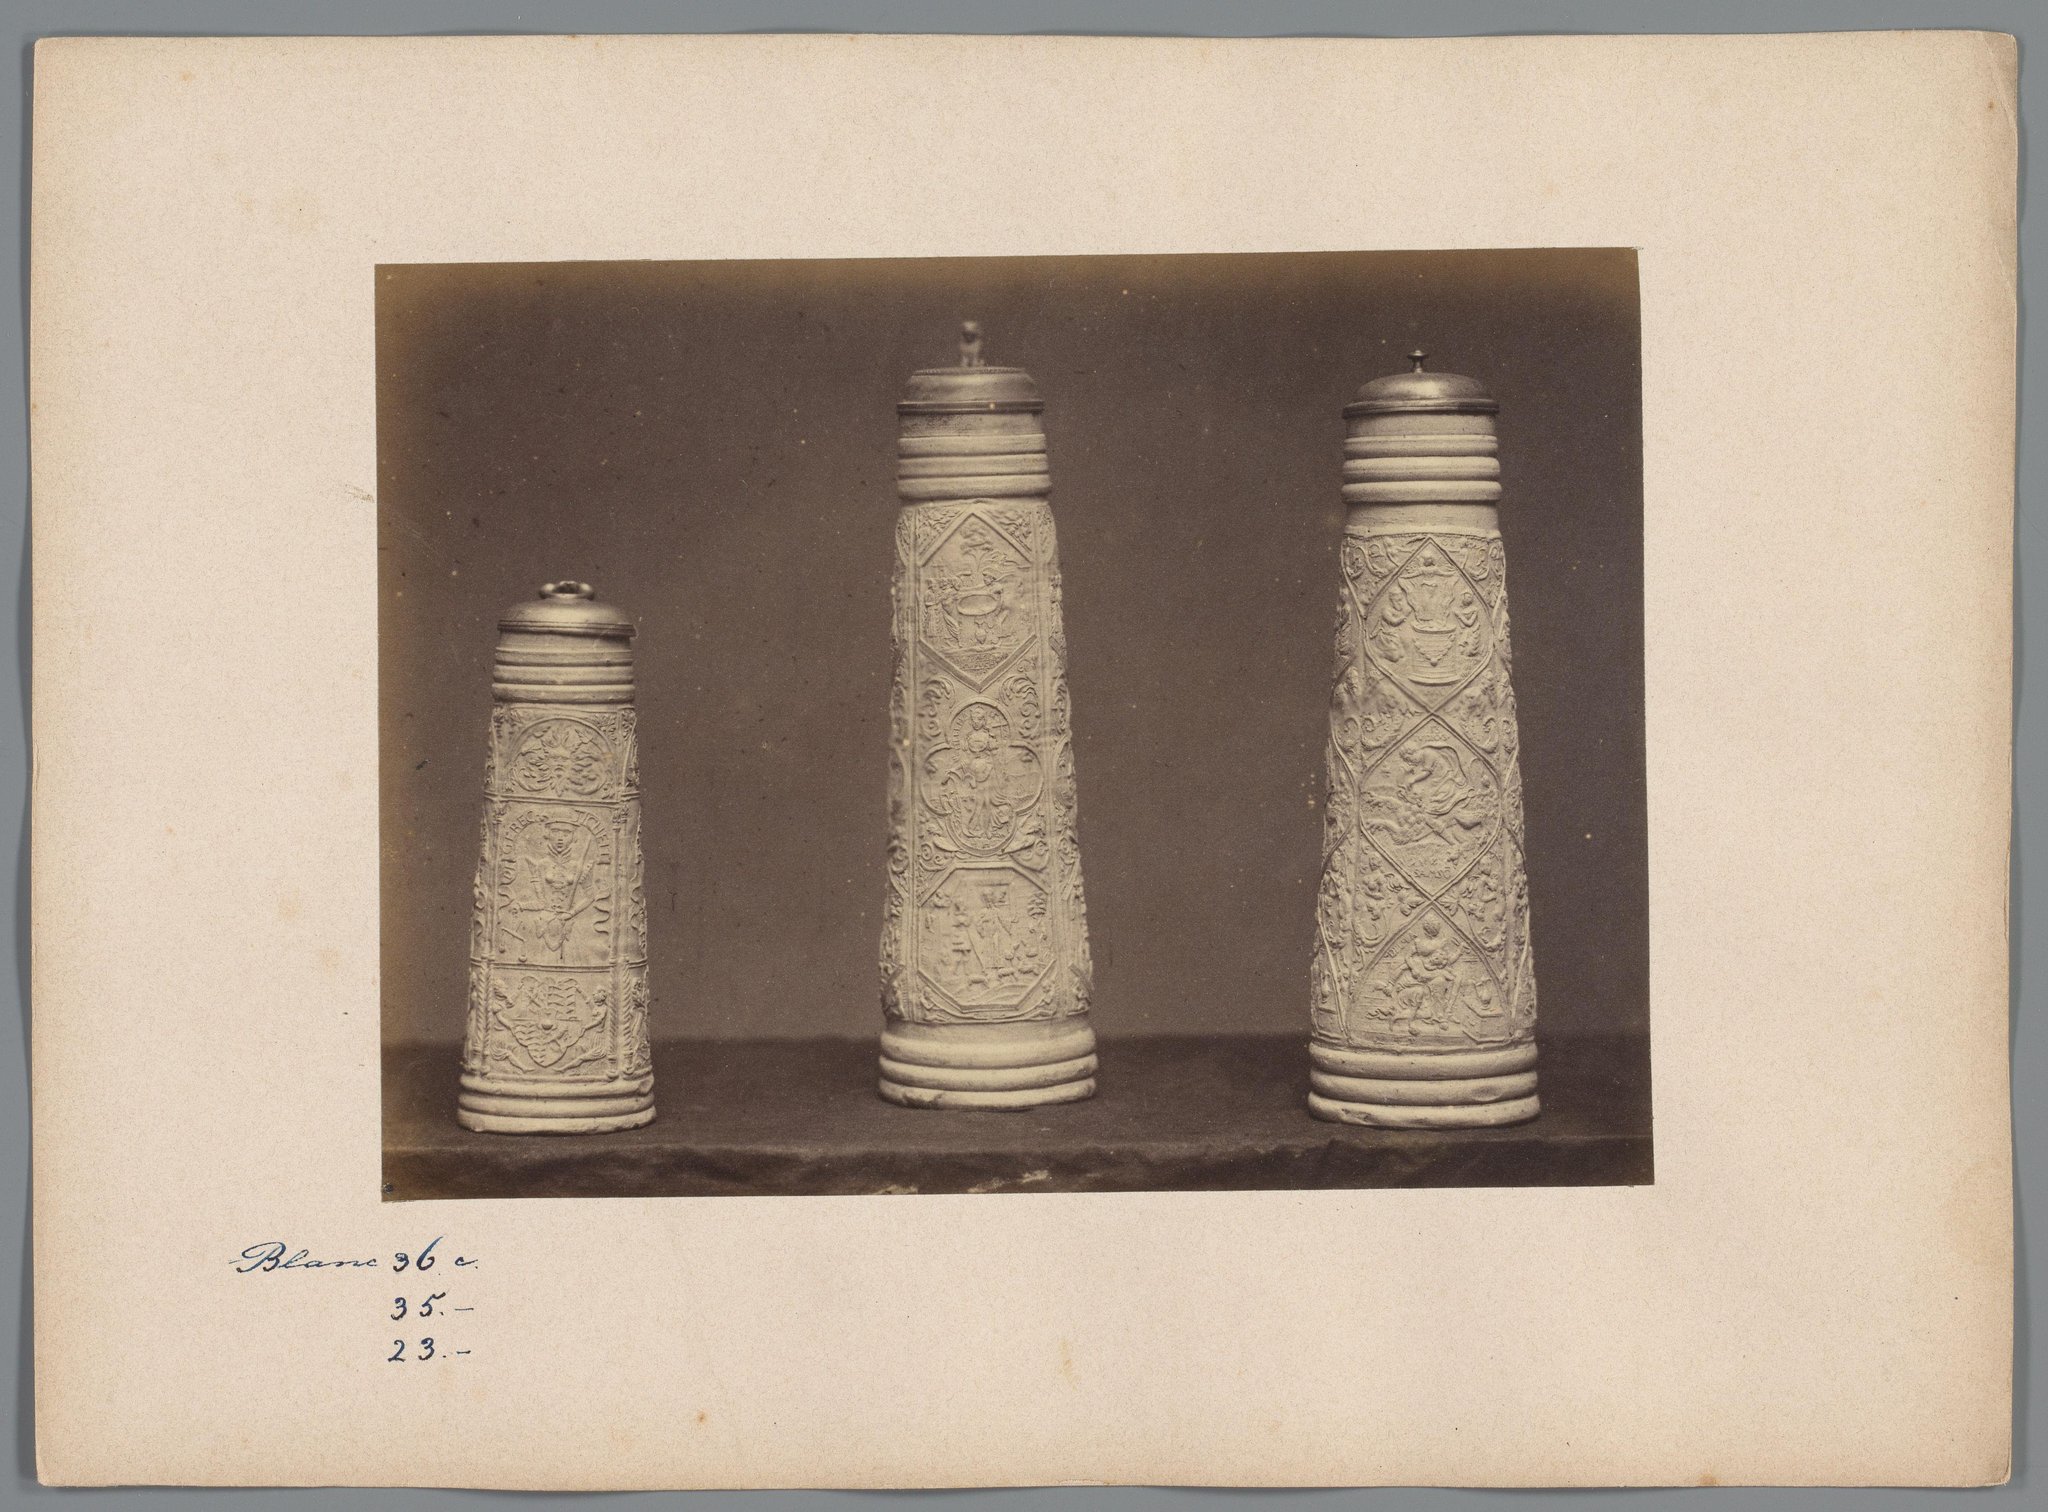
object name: photograph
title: Drie aardewerken vaas uit de collectie van W. de Weckherlin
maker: Anonymous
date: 1860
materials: paper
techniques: albumen print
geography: the hague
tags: container of ceramics: jar, jug, pot, vase, the hague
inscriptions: inscription: ‘Blanc 36c./ 35.-/ 23.-’